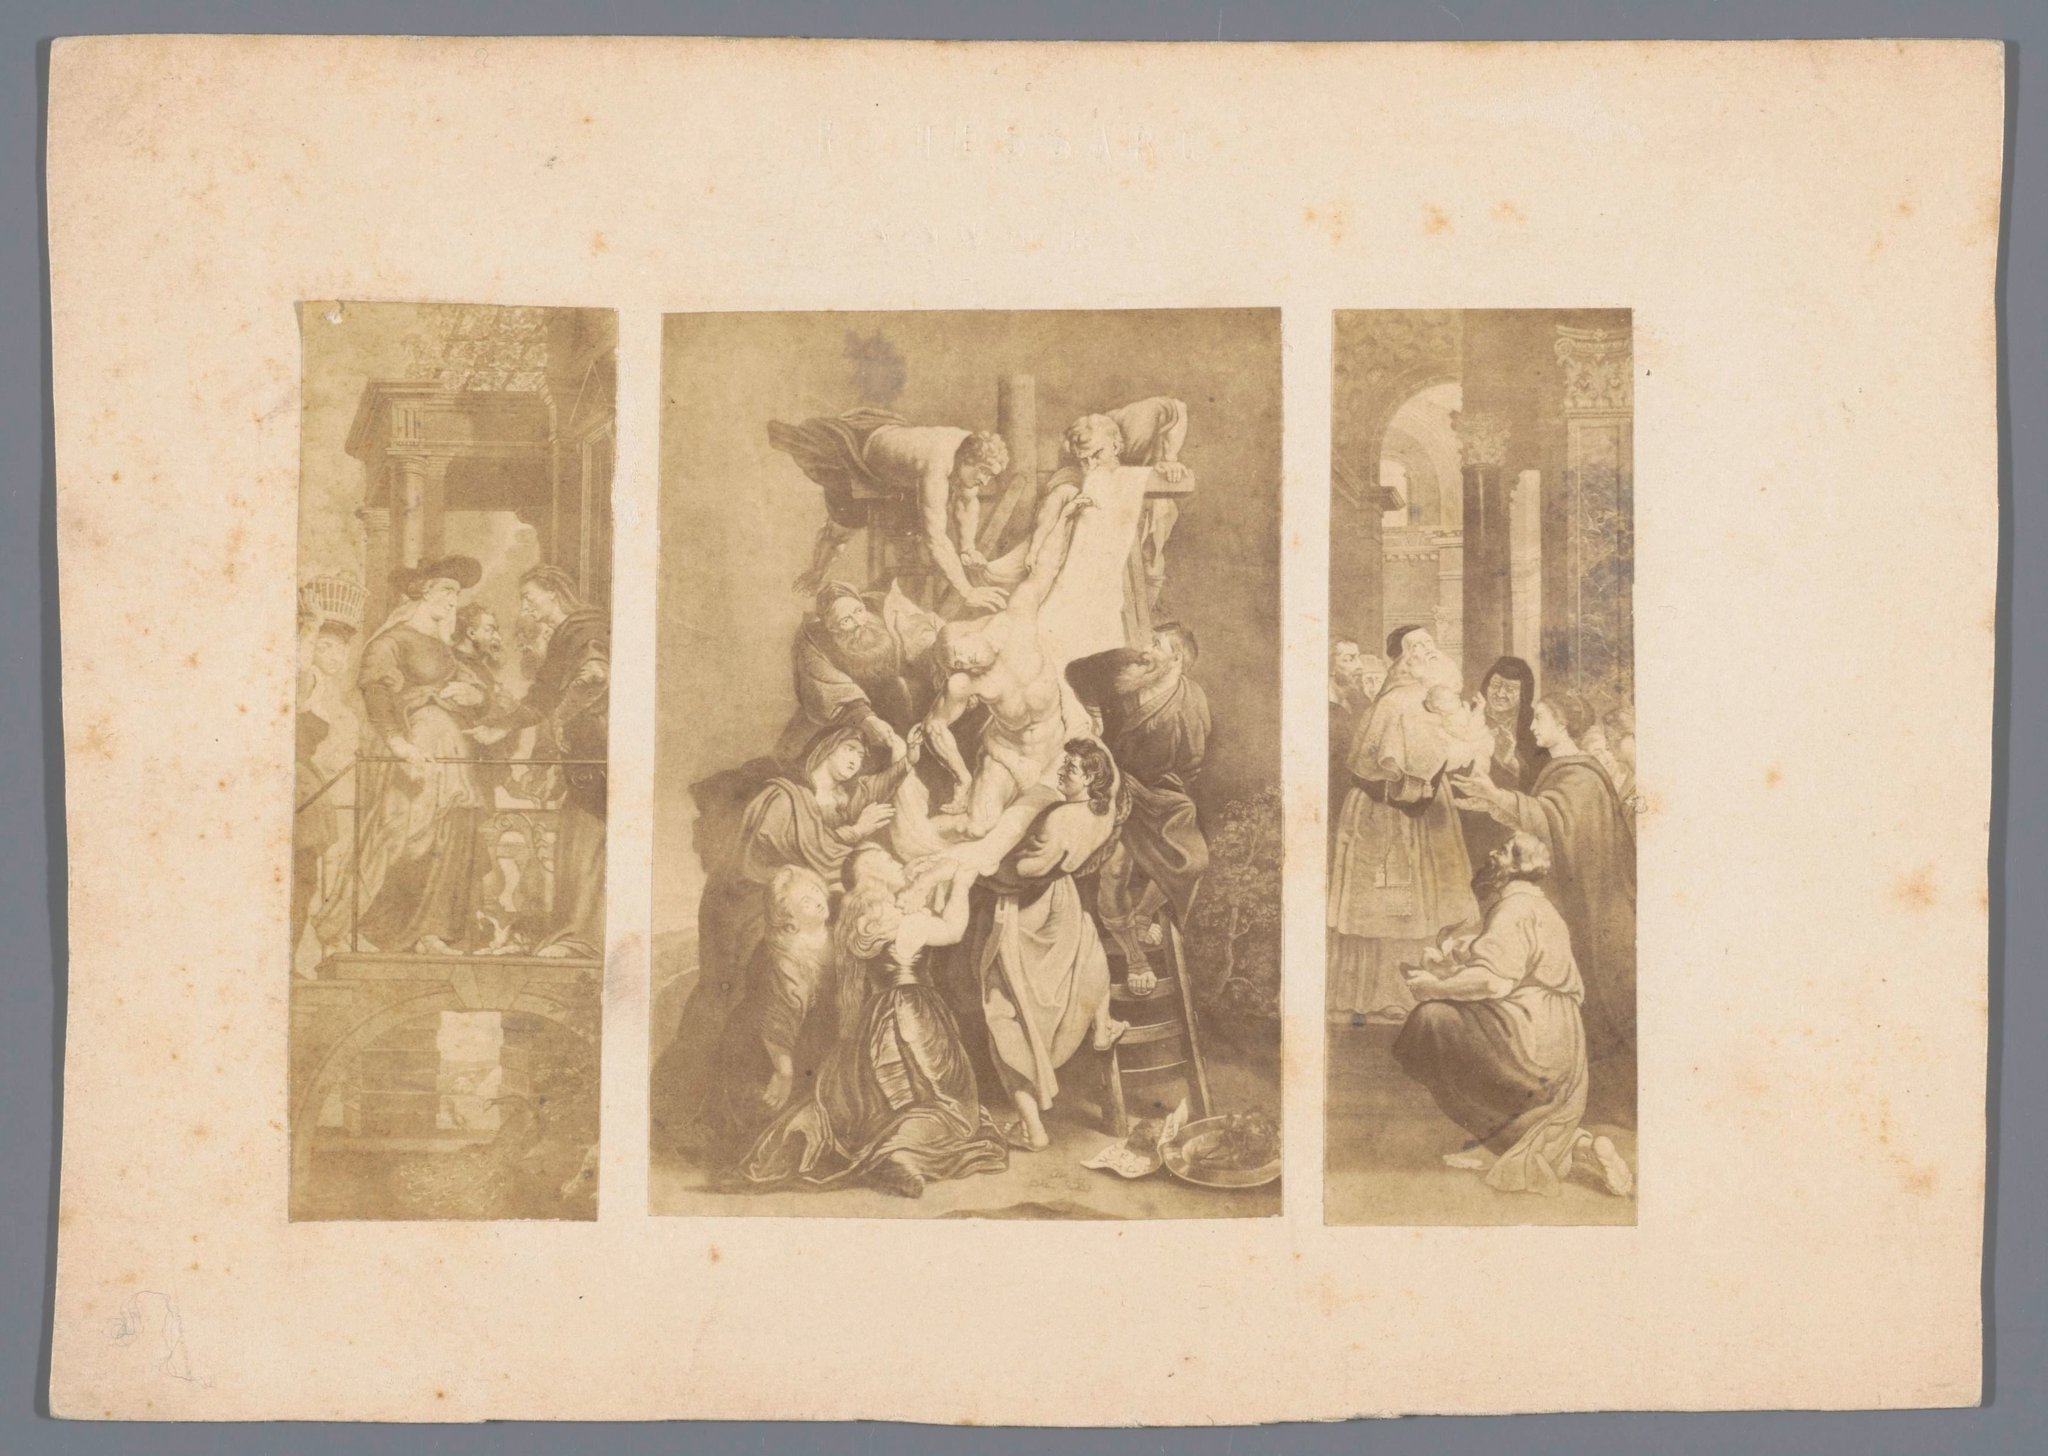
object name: photograph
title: Fotoreproductie van een prent van het drieluik de Kruisafneming naar Peter Paul Rubens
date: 1858-1866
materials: cardboard, paper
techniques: albumen print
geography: antwerp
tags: descent from the cross: christ is taken down from the cross, usually by nicodemus and joseph of arimathaea who are standing on the ladders (both arms of christ detached)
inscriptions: check stamp: ‘F. TESSARO / ANVERS’, inscription: ‘10€’